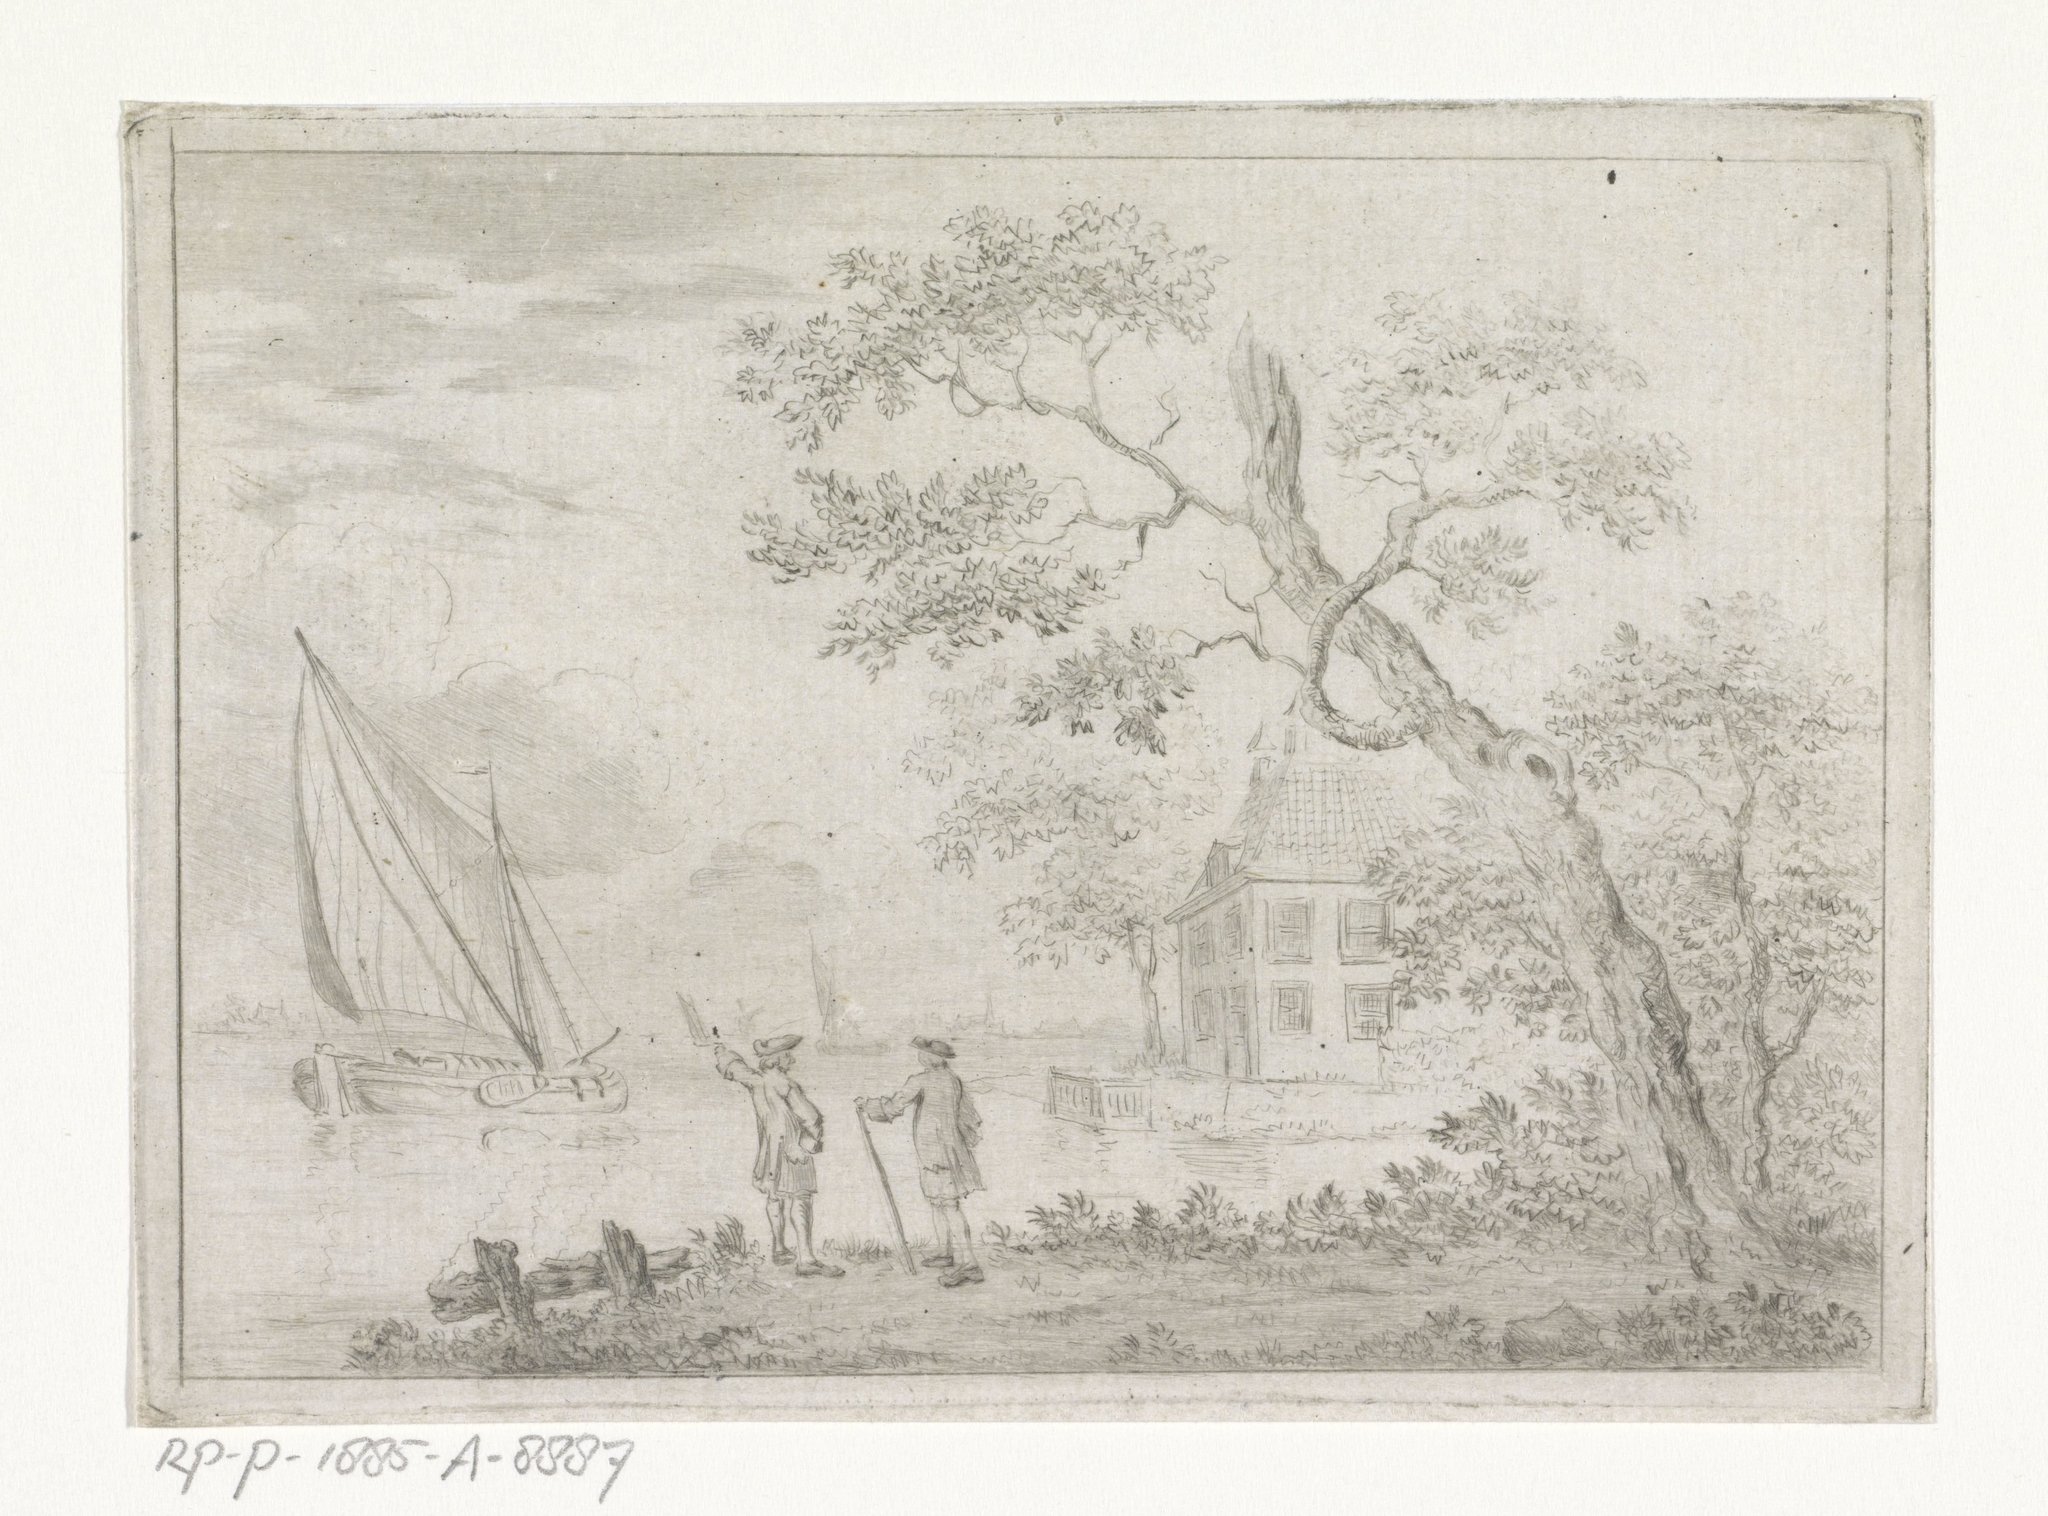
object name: print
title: Gezicht op een meer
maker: Anonymous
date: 1700-1800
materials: paper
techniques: etching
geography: netherlands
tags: sailing-ship, sailing-boat, index finger forwards, pointing, indicating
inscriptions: collector's mark: Lugt 2228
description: Twee mannen kijken uit over een meer met zeilschepen. De linker man wijst op het dichtstbijzijnde zeilschip. Rechts een huis aan het water.